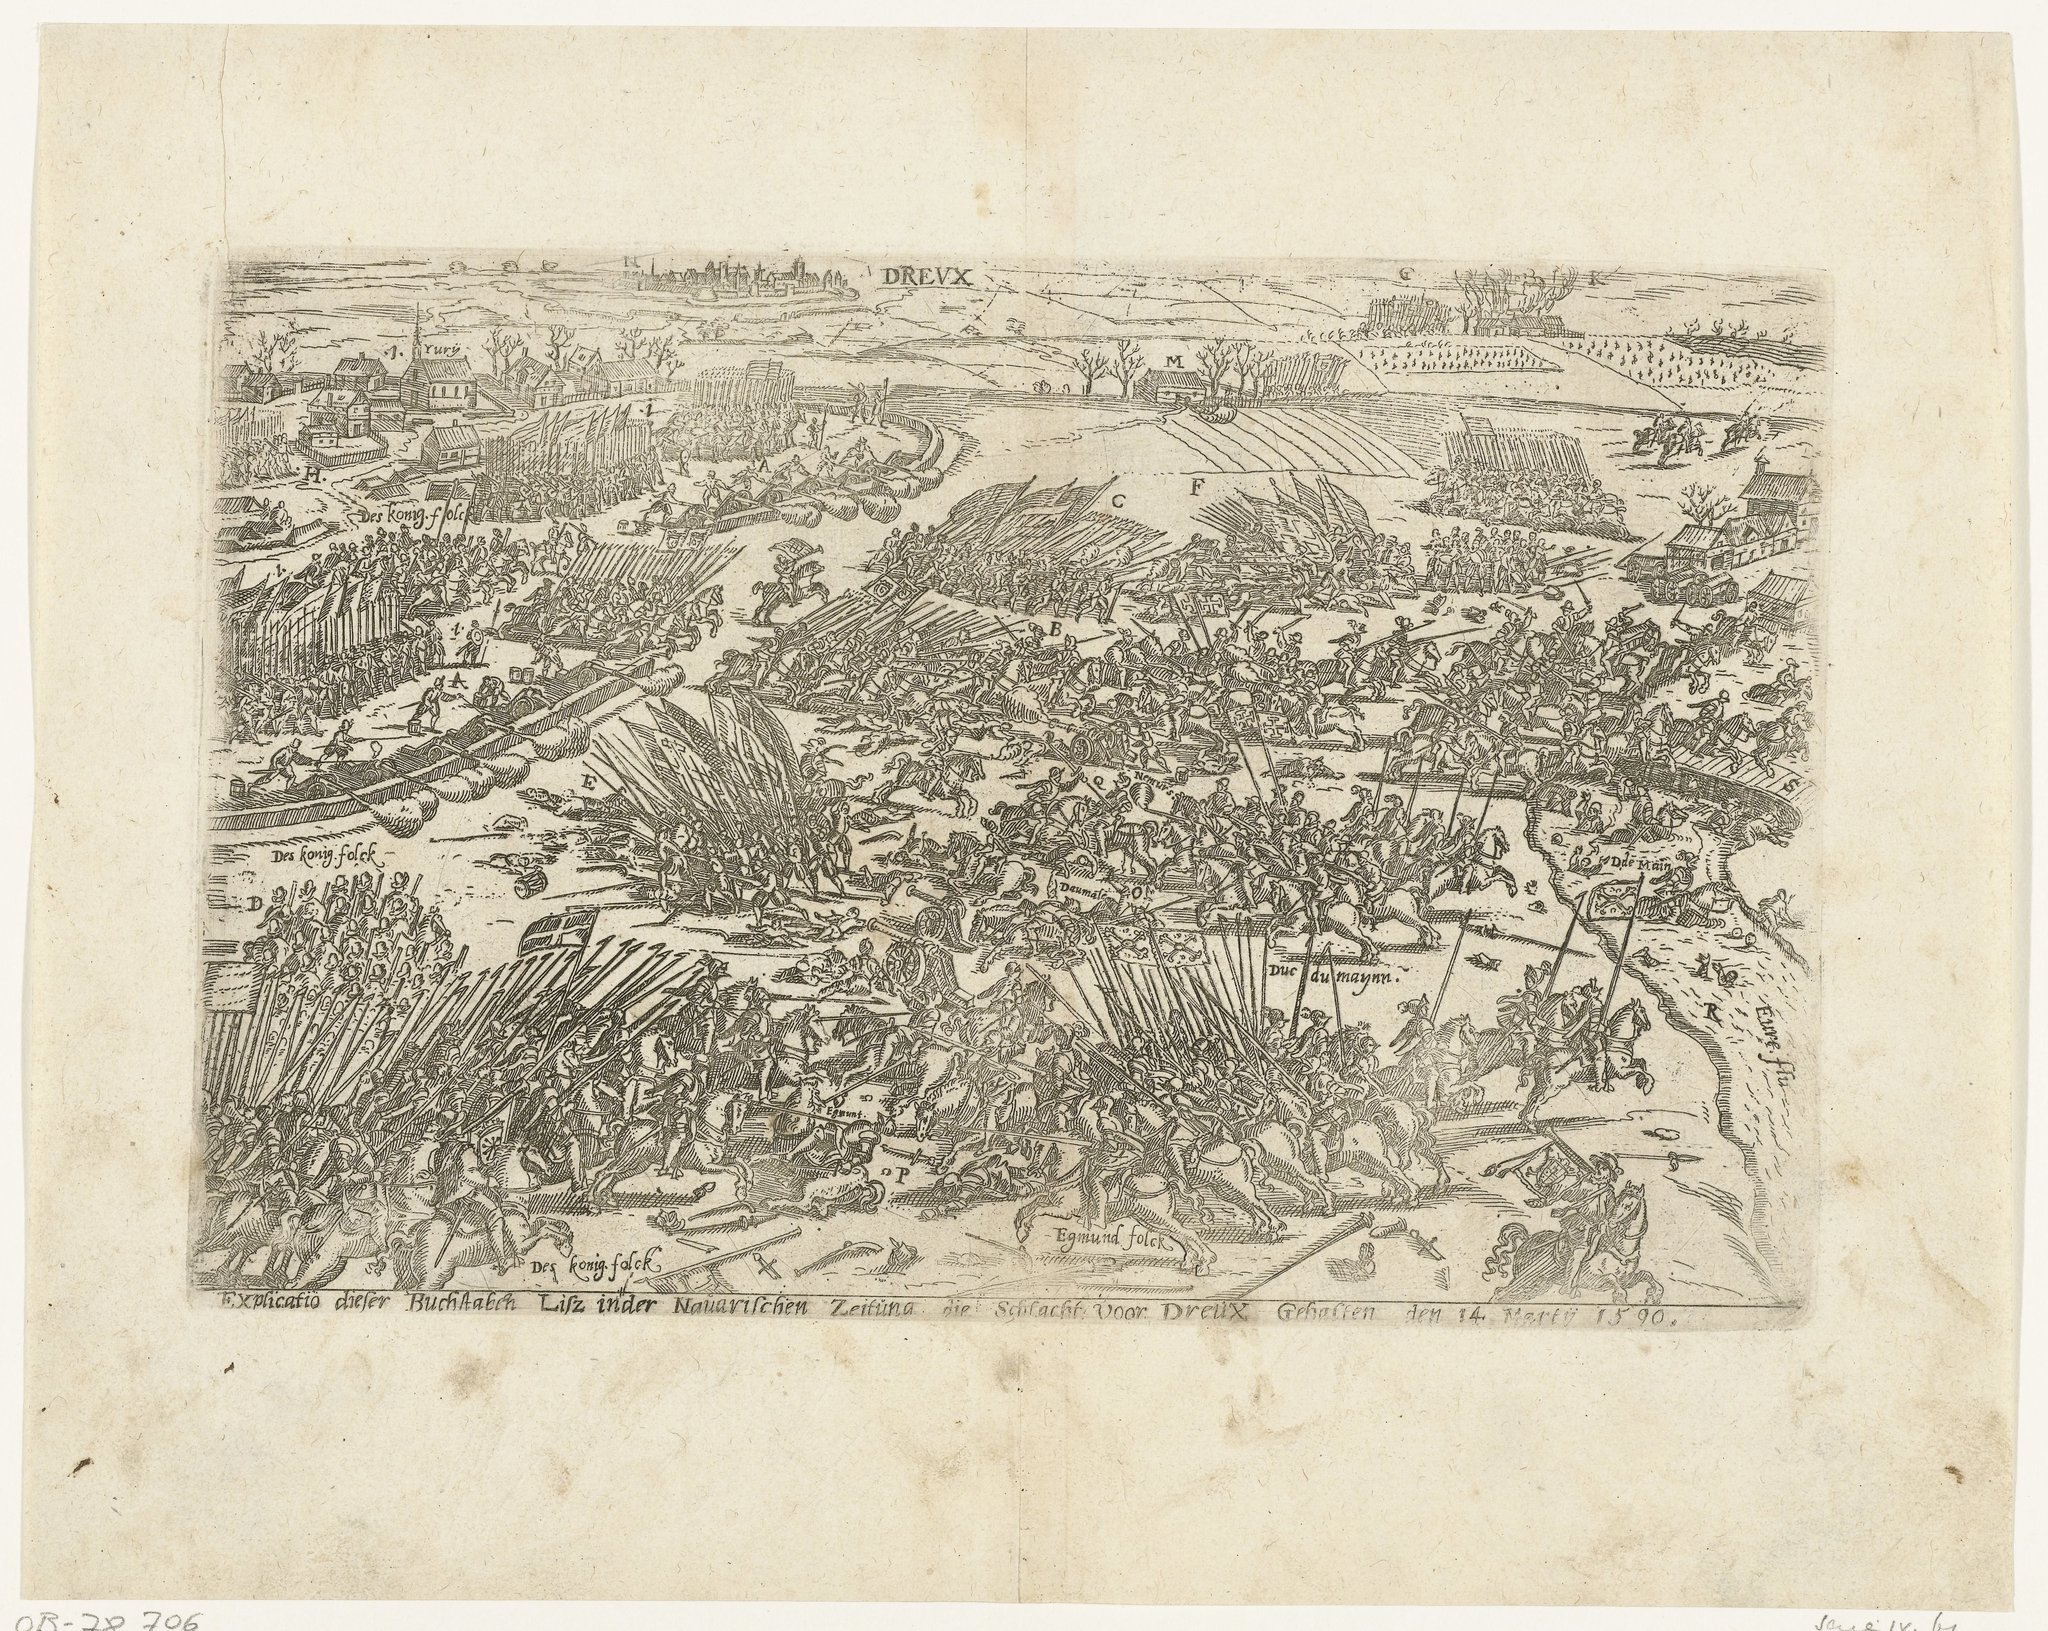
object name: print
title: Slag bij Ivry (Dreux), 1590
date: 1590-1592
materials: paper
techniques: etching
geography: germany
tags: paris, hendrik iv (koning van frankrijk en navarra), battle, fighting in general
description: Gezicht op de veldslag bij Ivry (Dreux), 14 maart 1590. In de verte de ommuurde stad. Met onderschrift van 1 regel in het Duits waarin voor details over deze slag wordt verwezen naar de Navarrischen Zeitung. Kopie naar de prent van Hogenberg. Ongenummerd.